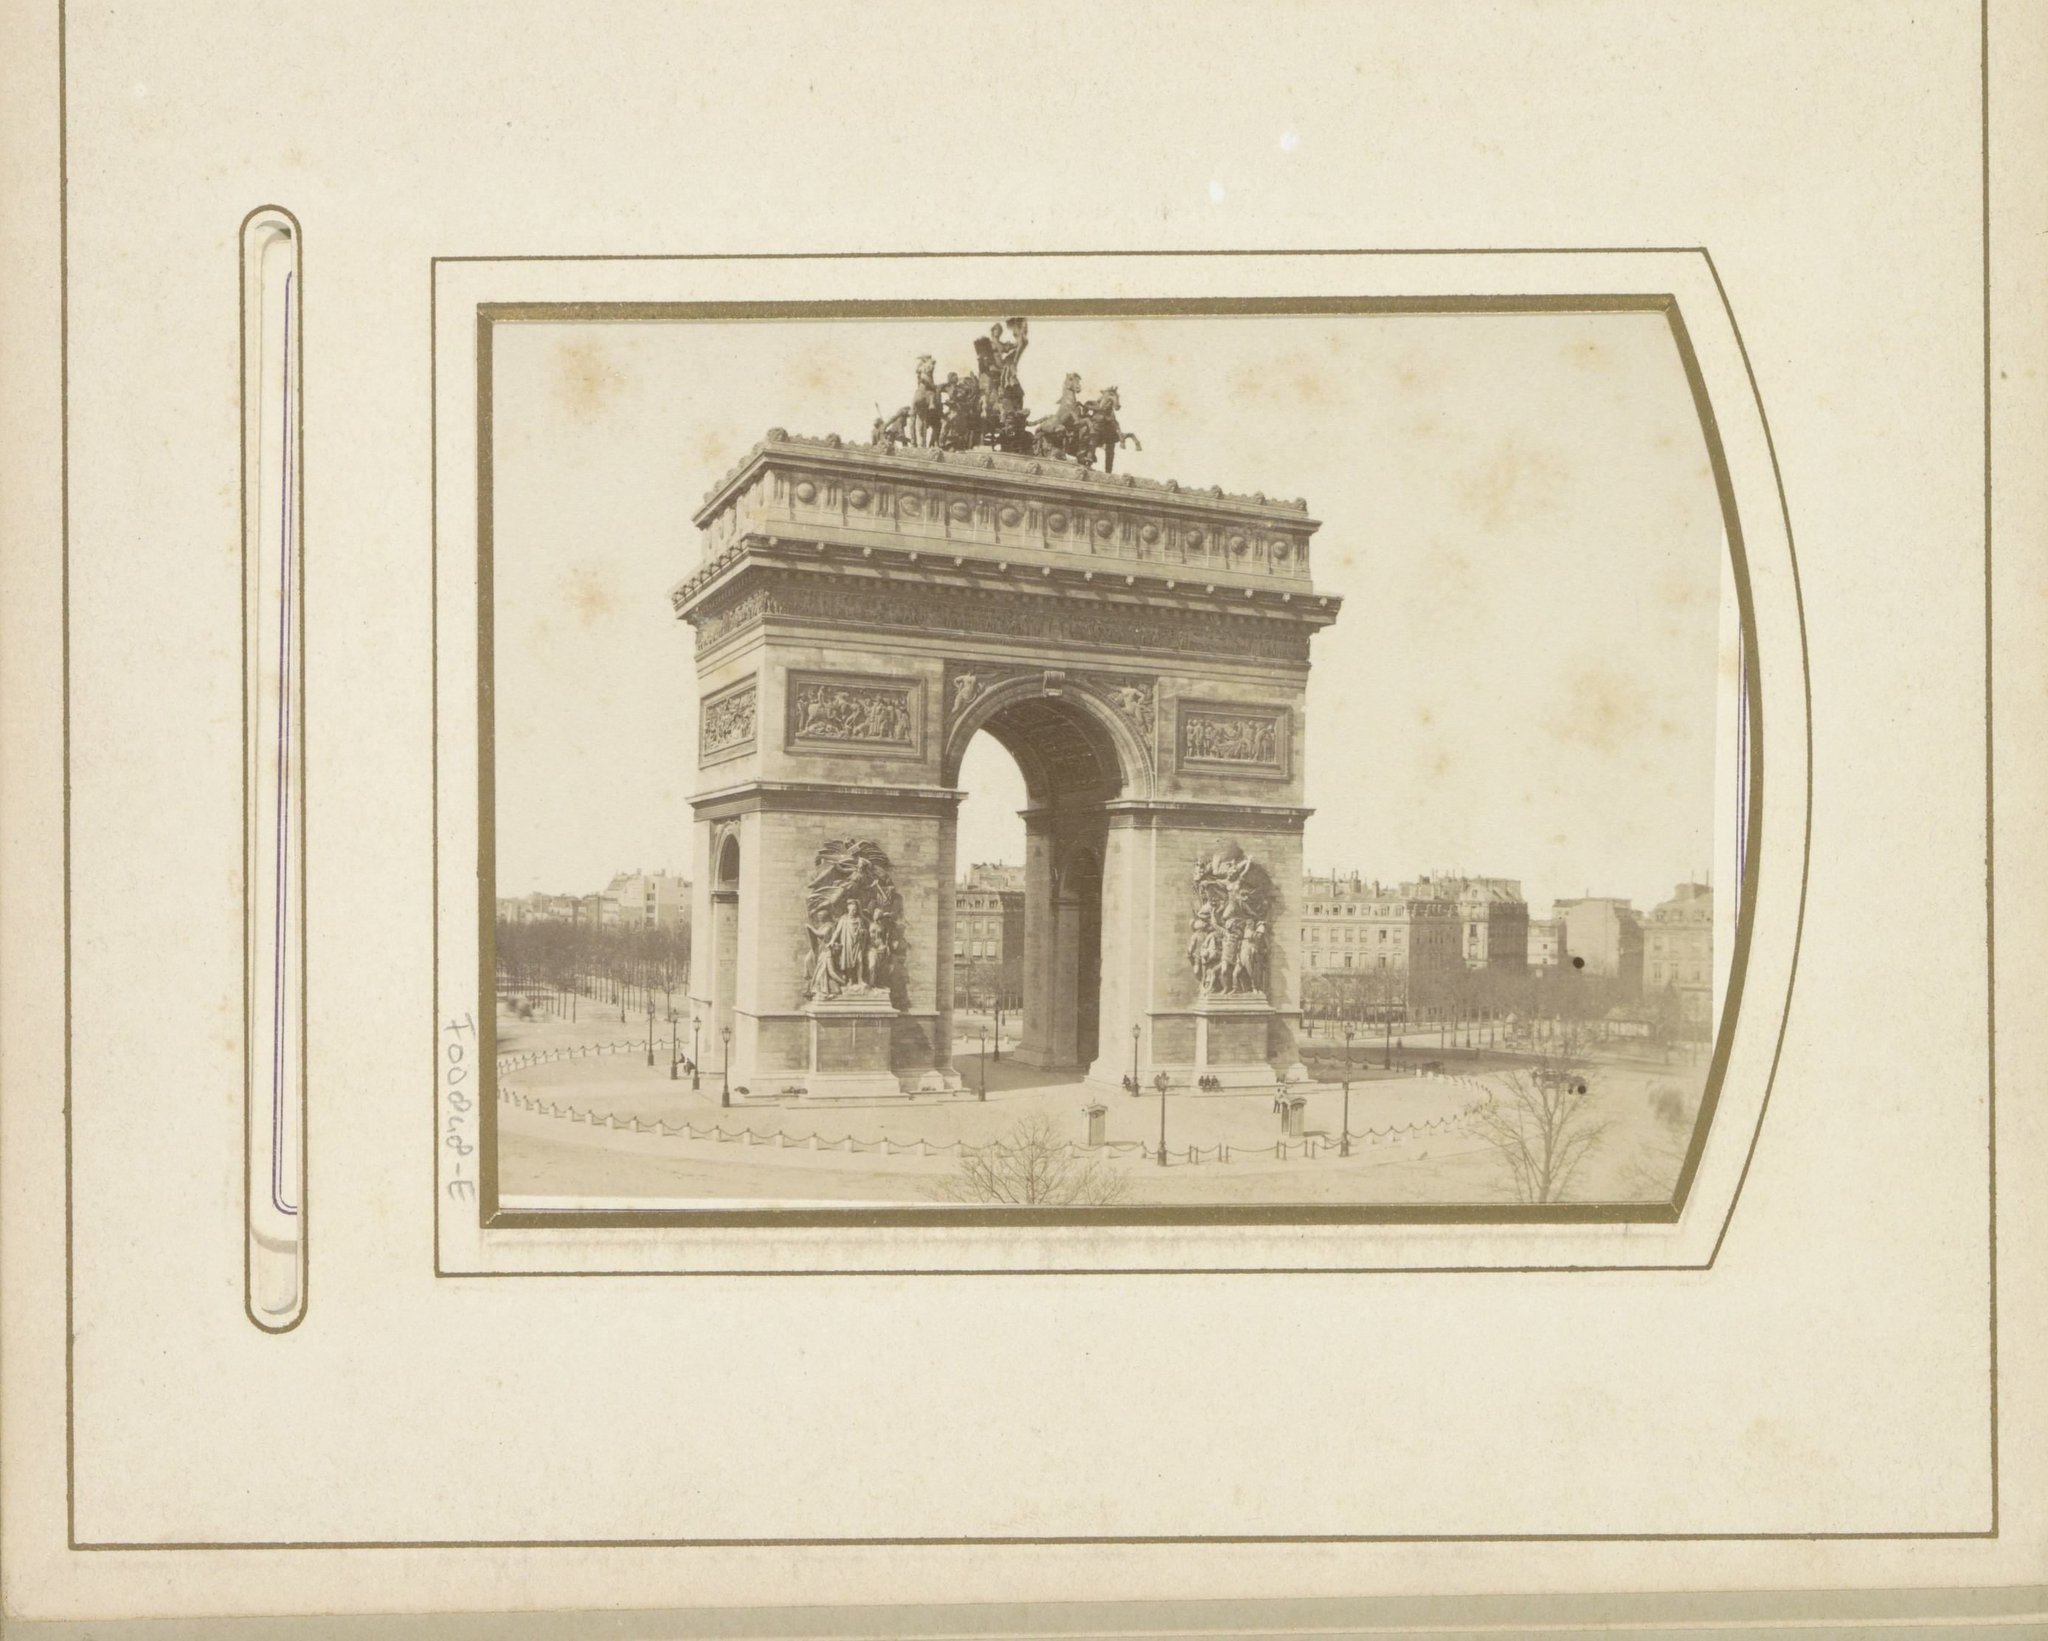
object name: cabinet photograph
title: Arc de Triomphe in Parijs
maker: Anonymous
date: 1870-1900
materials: cardboard, paper, photographic support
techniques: albumen print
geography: paris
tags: triumphal arch, paris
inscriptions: inscription: ‘Arc de Triomphe’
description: Onderdeel van Fotoalbum met kabinetfoto's van bezienswaardigheden in Parijs en Versailles.